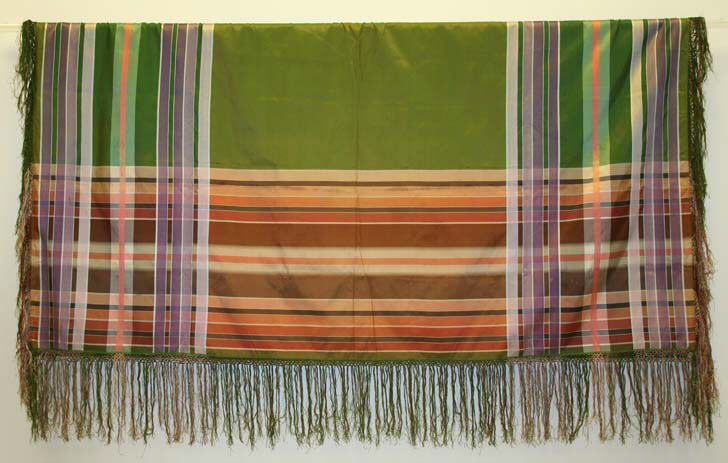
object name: shawl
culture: british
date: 1840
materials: silk